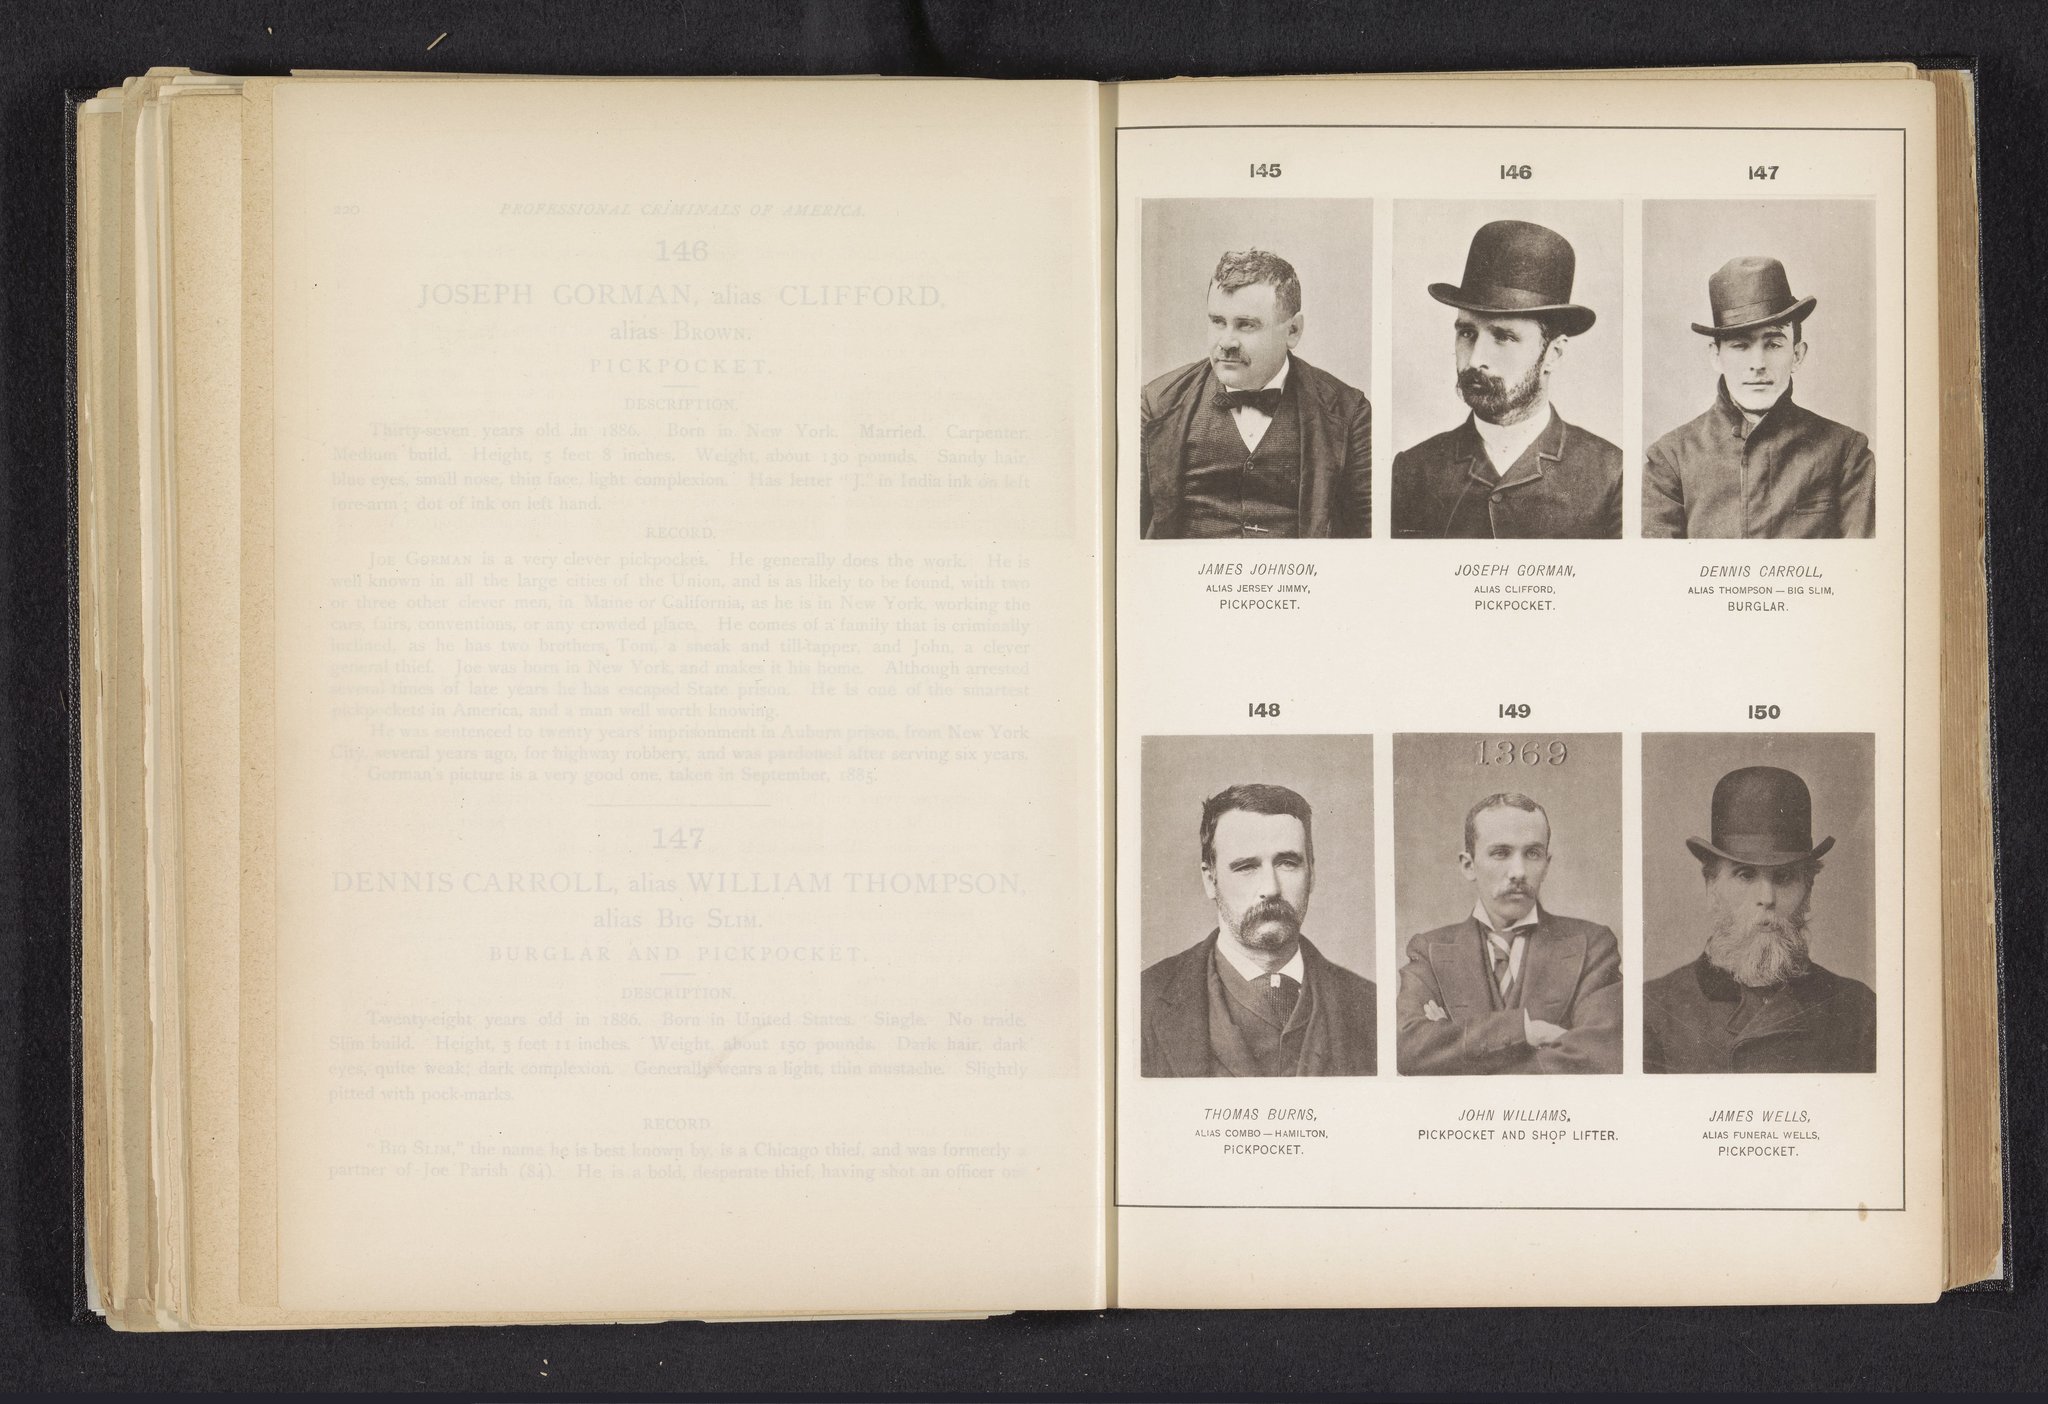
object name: photomechanical print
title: Zes portretten van zakkenrollers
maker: Anonymous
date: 1881-1886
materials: paper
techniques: photograph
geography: boston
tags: historical persons not known by name (+ (full) bust portrait), pickpocket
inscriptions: inscription: ‘James Johnson (...) pickpocket.’, number: ‘145 (...) 150’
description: Linksboven James Johnson, midden boven Joseph Gorman, rechtsboven Dennis Carroll, linksonder Thomas Burns, midden onder John Williams, rechtsonder James Wells.